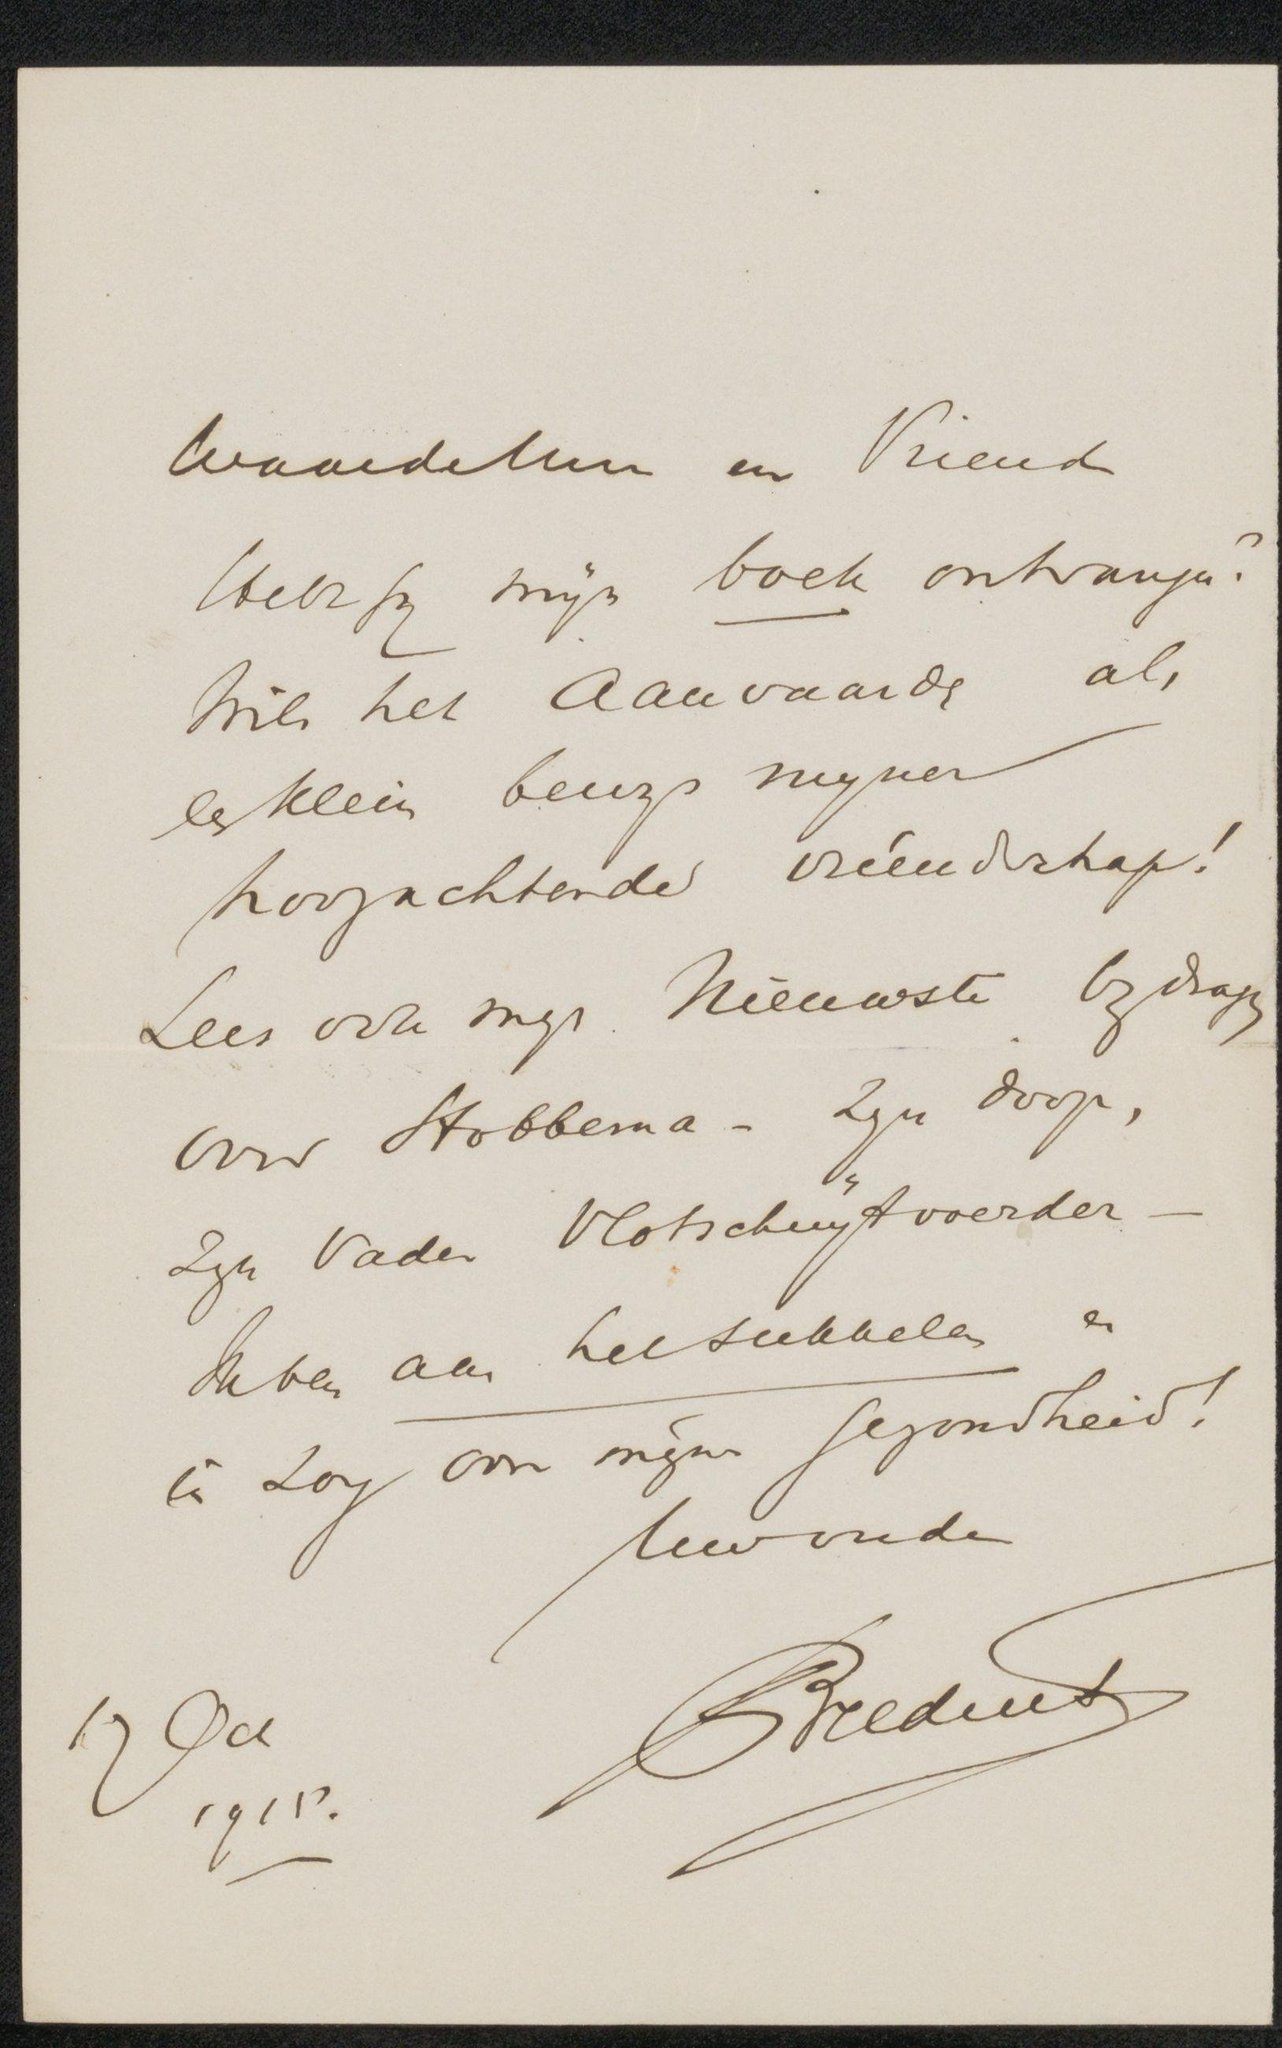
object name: letter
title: Brief aan August Allebé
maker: abraham bredius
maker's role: kunsthistoricus, museumdirecteur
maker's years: 1855-1946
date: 1918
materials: ink, paper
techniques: pen, writing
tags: august allebé, painter, draughtsman, meindert hobbema, diseases, printed matter